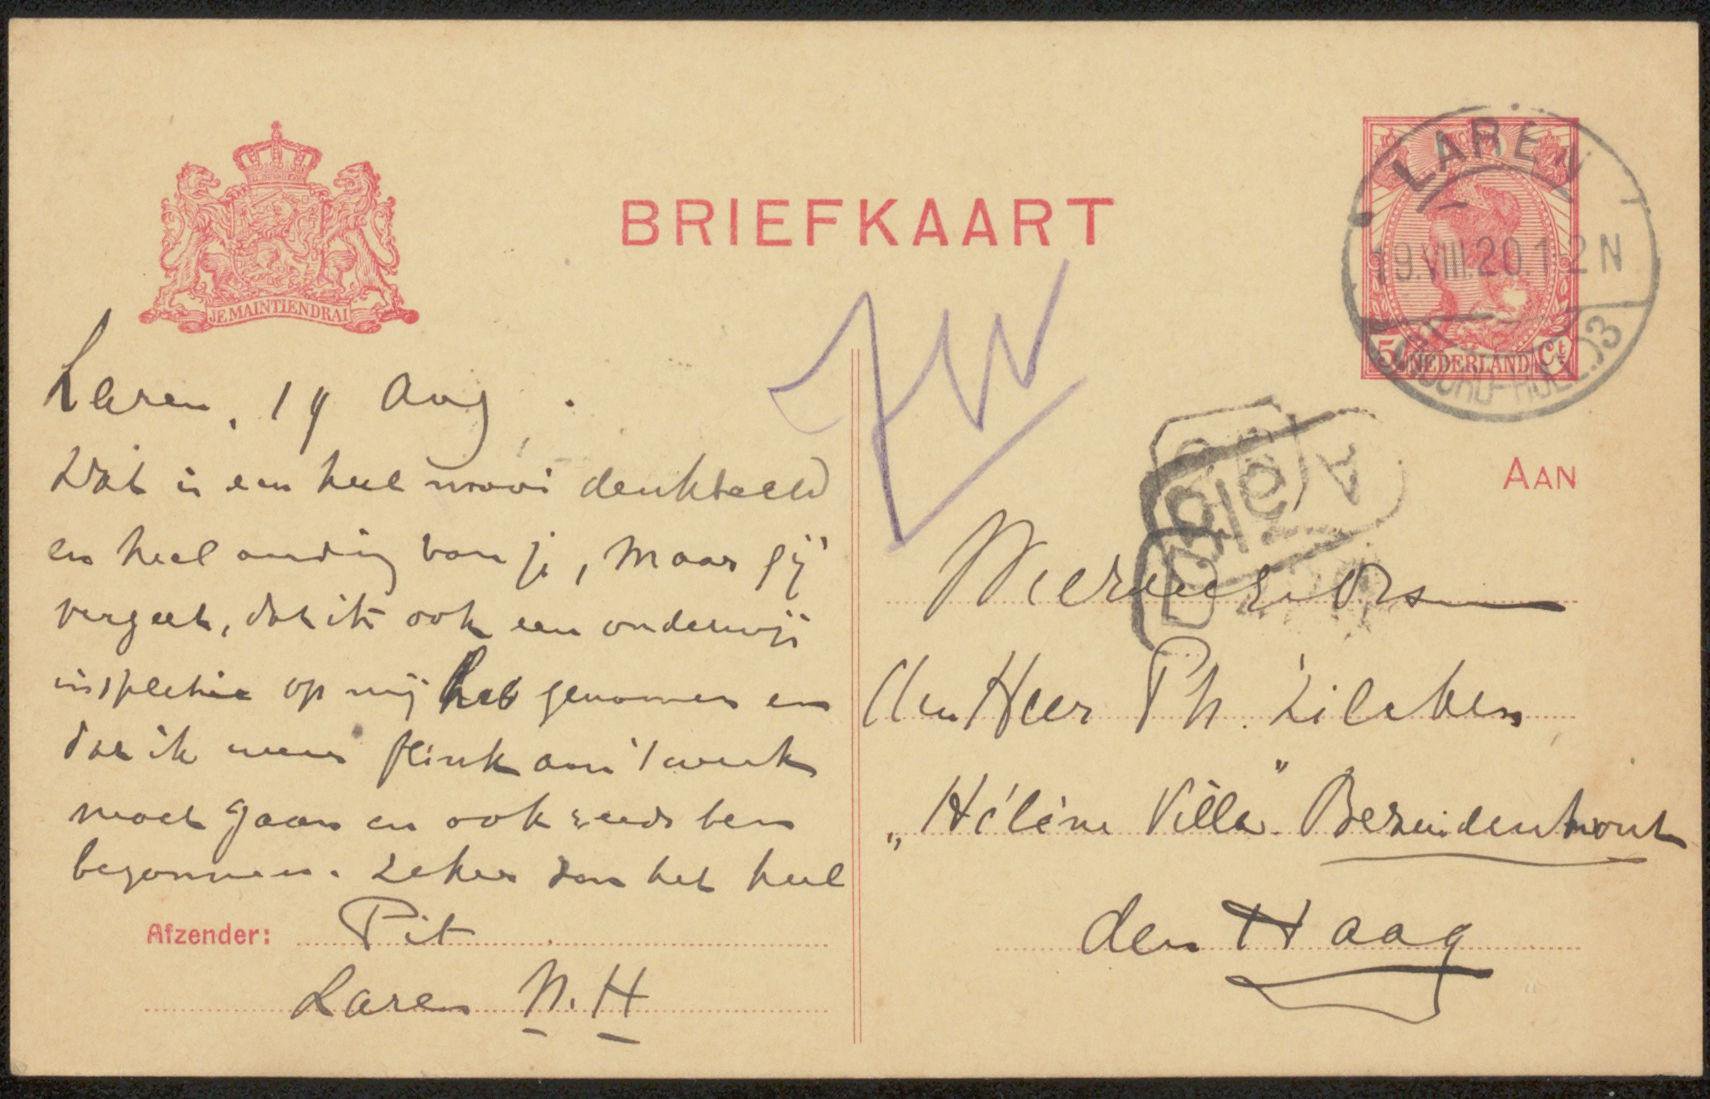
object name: postcard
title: Briefkaart aan Philip Zilcken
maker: adriaan pit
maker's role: print maker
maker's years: 1860-1944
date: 1920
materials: cardboard, ink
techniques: pen, writing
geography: laren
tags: painter, draughtsman, philip zilcken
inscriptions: collector's mark: ‘RPK’